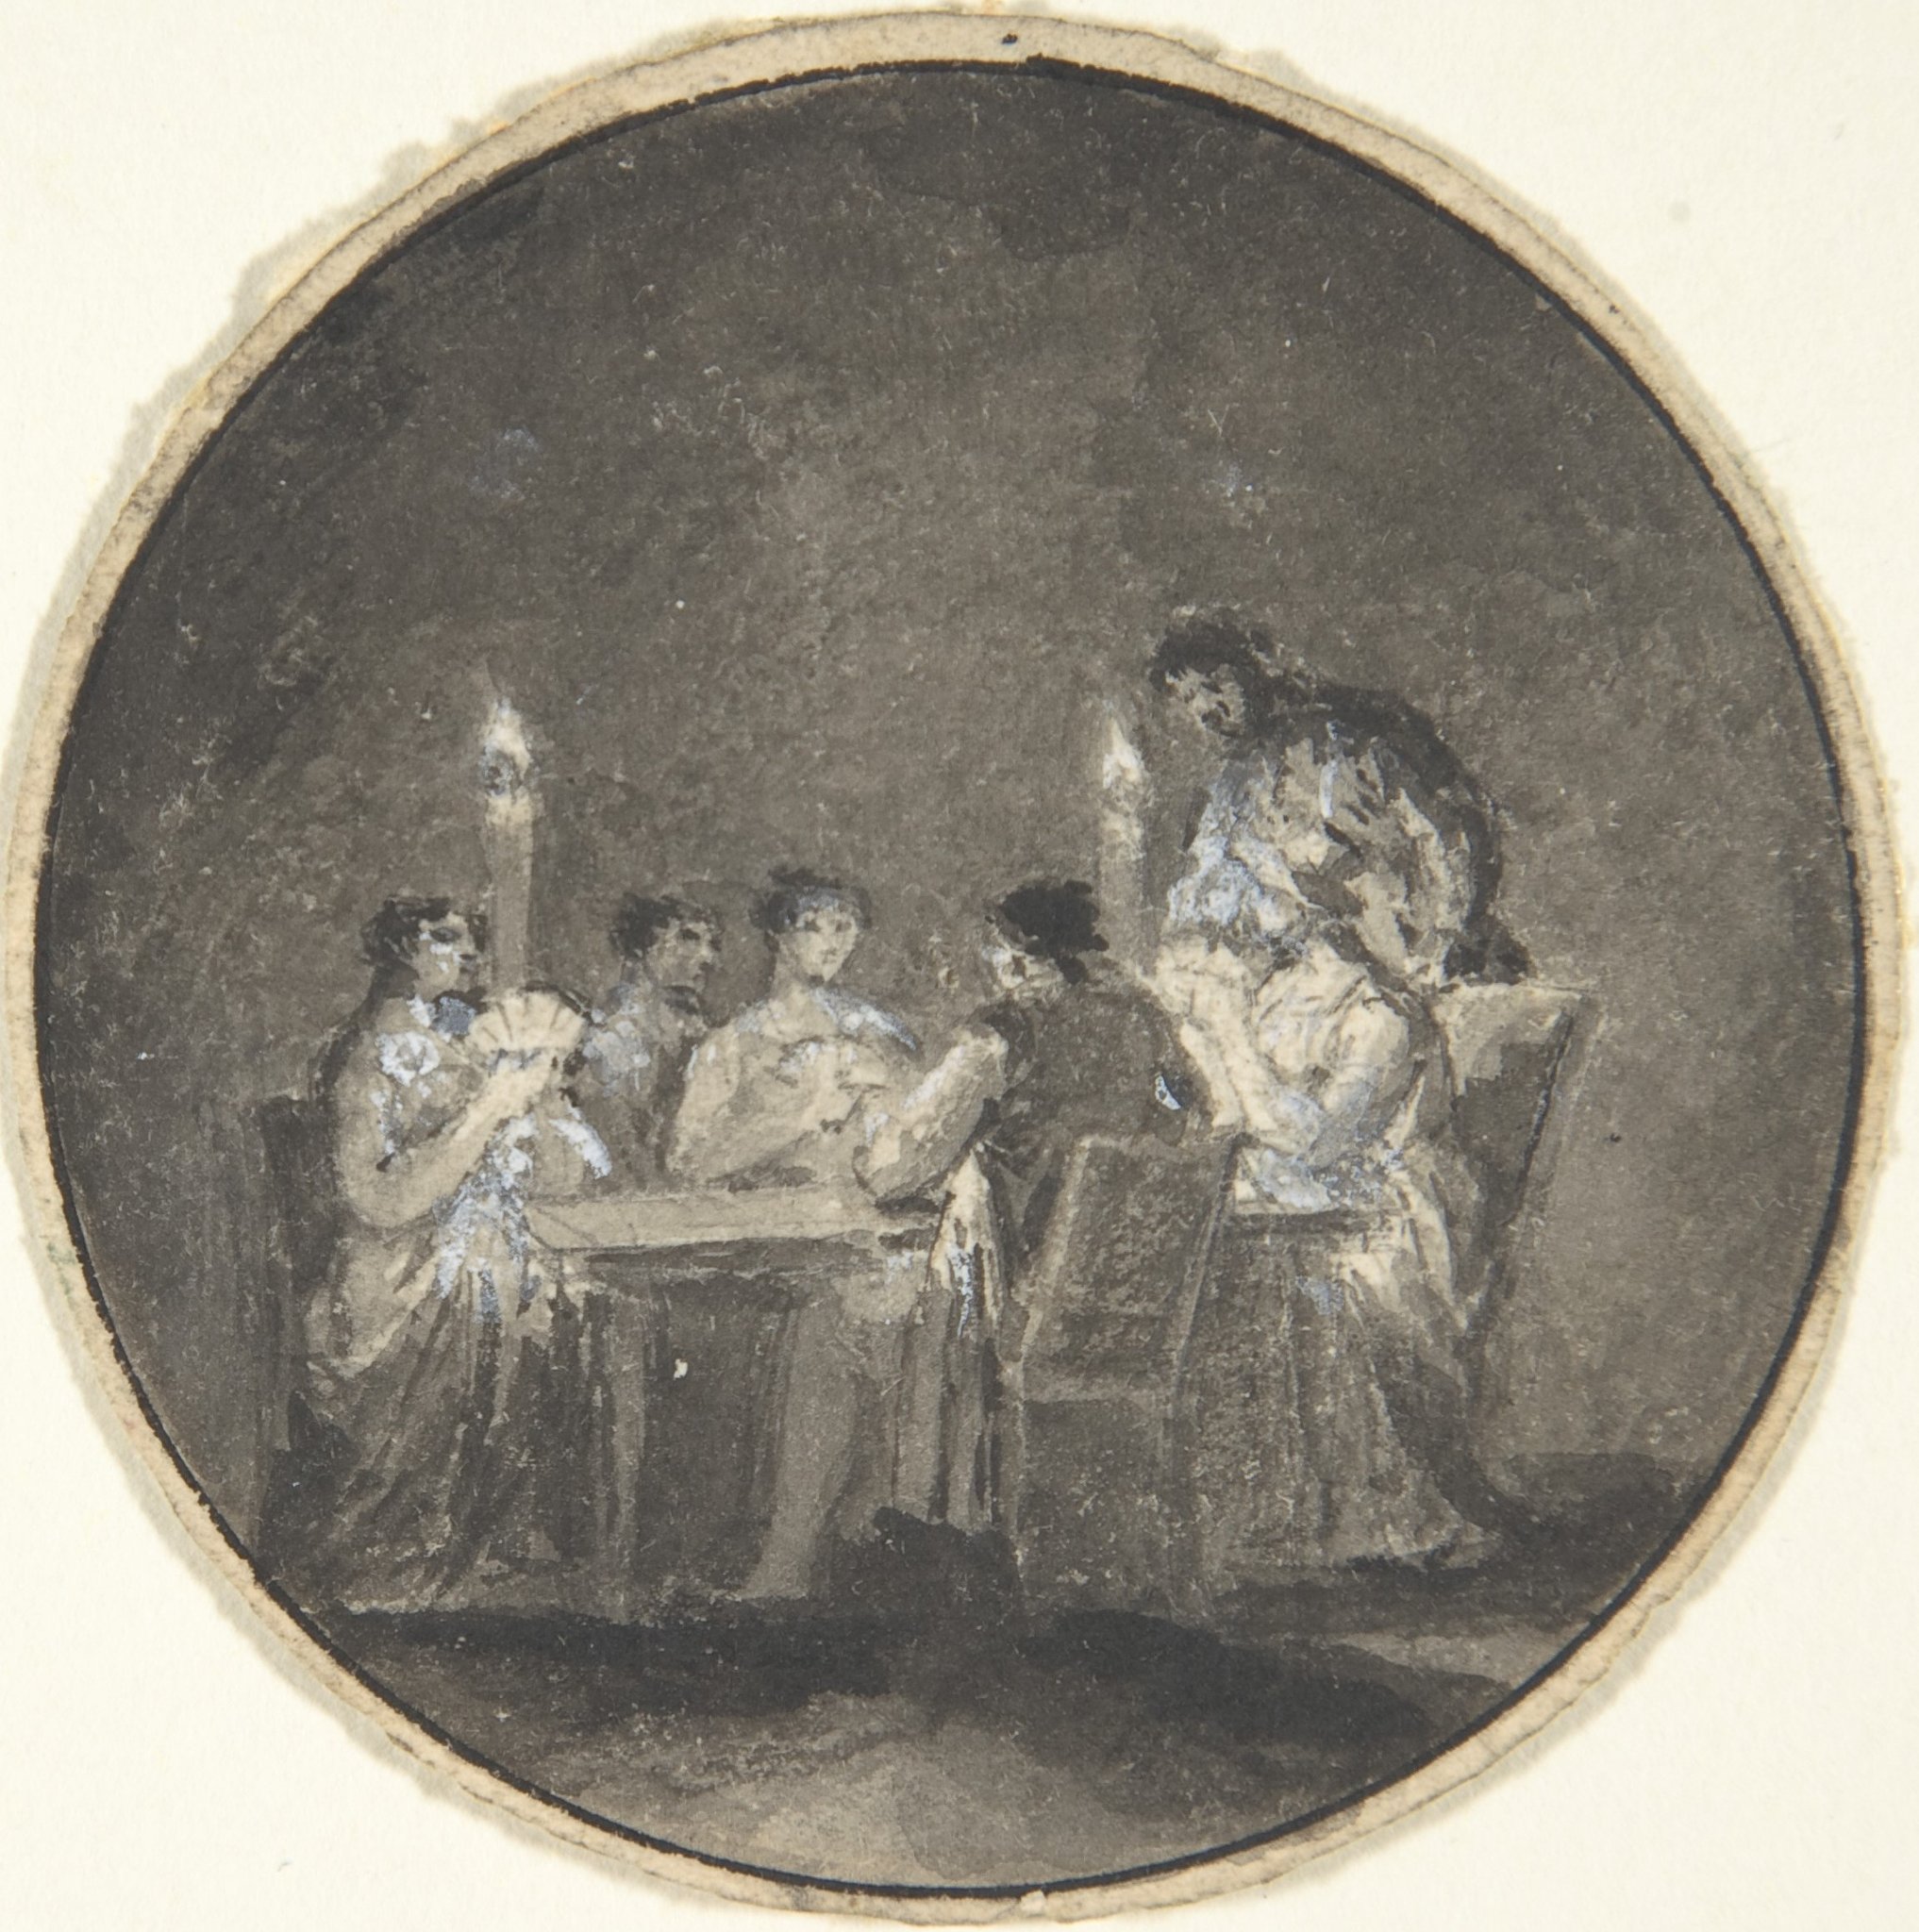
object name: drawing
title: The Card Players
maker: anonymous, british, 19th century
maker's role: artist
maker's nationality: british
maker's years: 1800-1900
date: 1780-1820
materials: gouache, ink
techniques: brush, heightening, wash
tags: human figures,playing cards